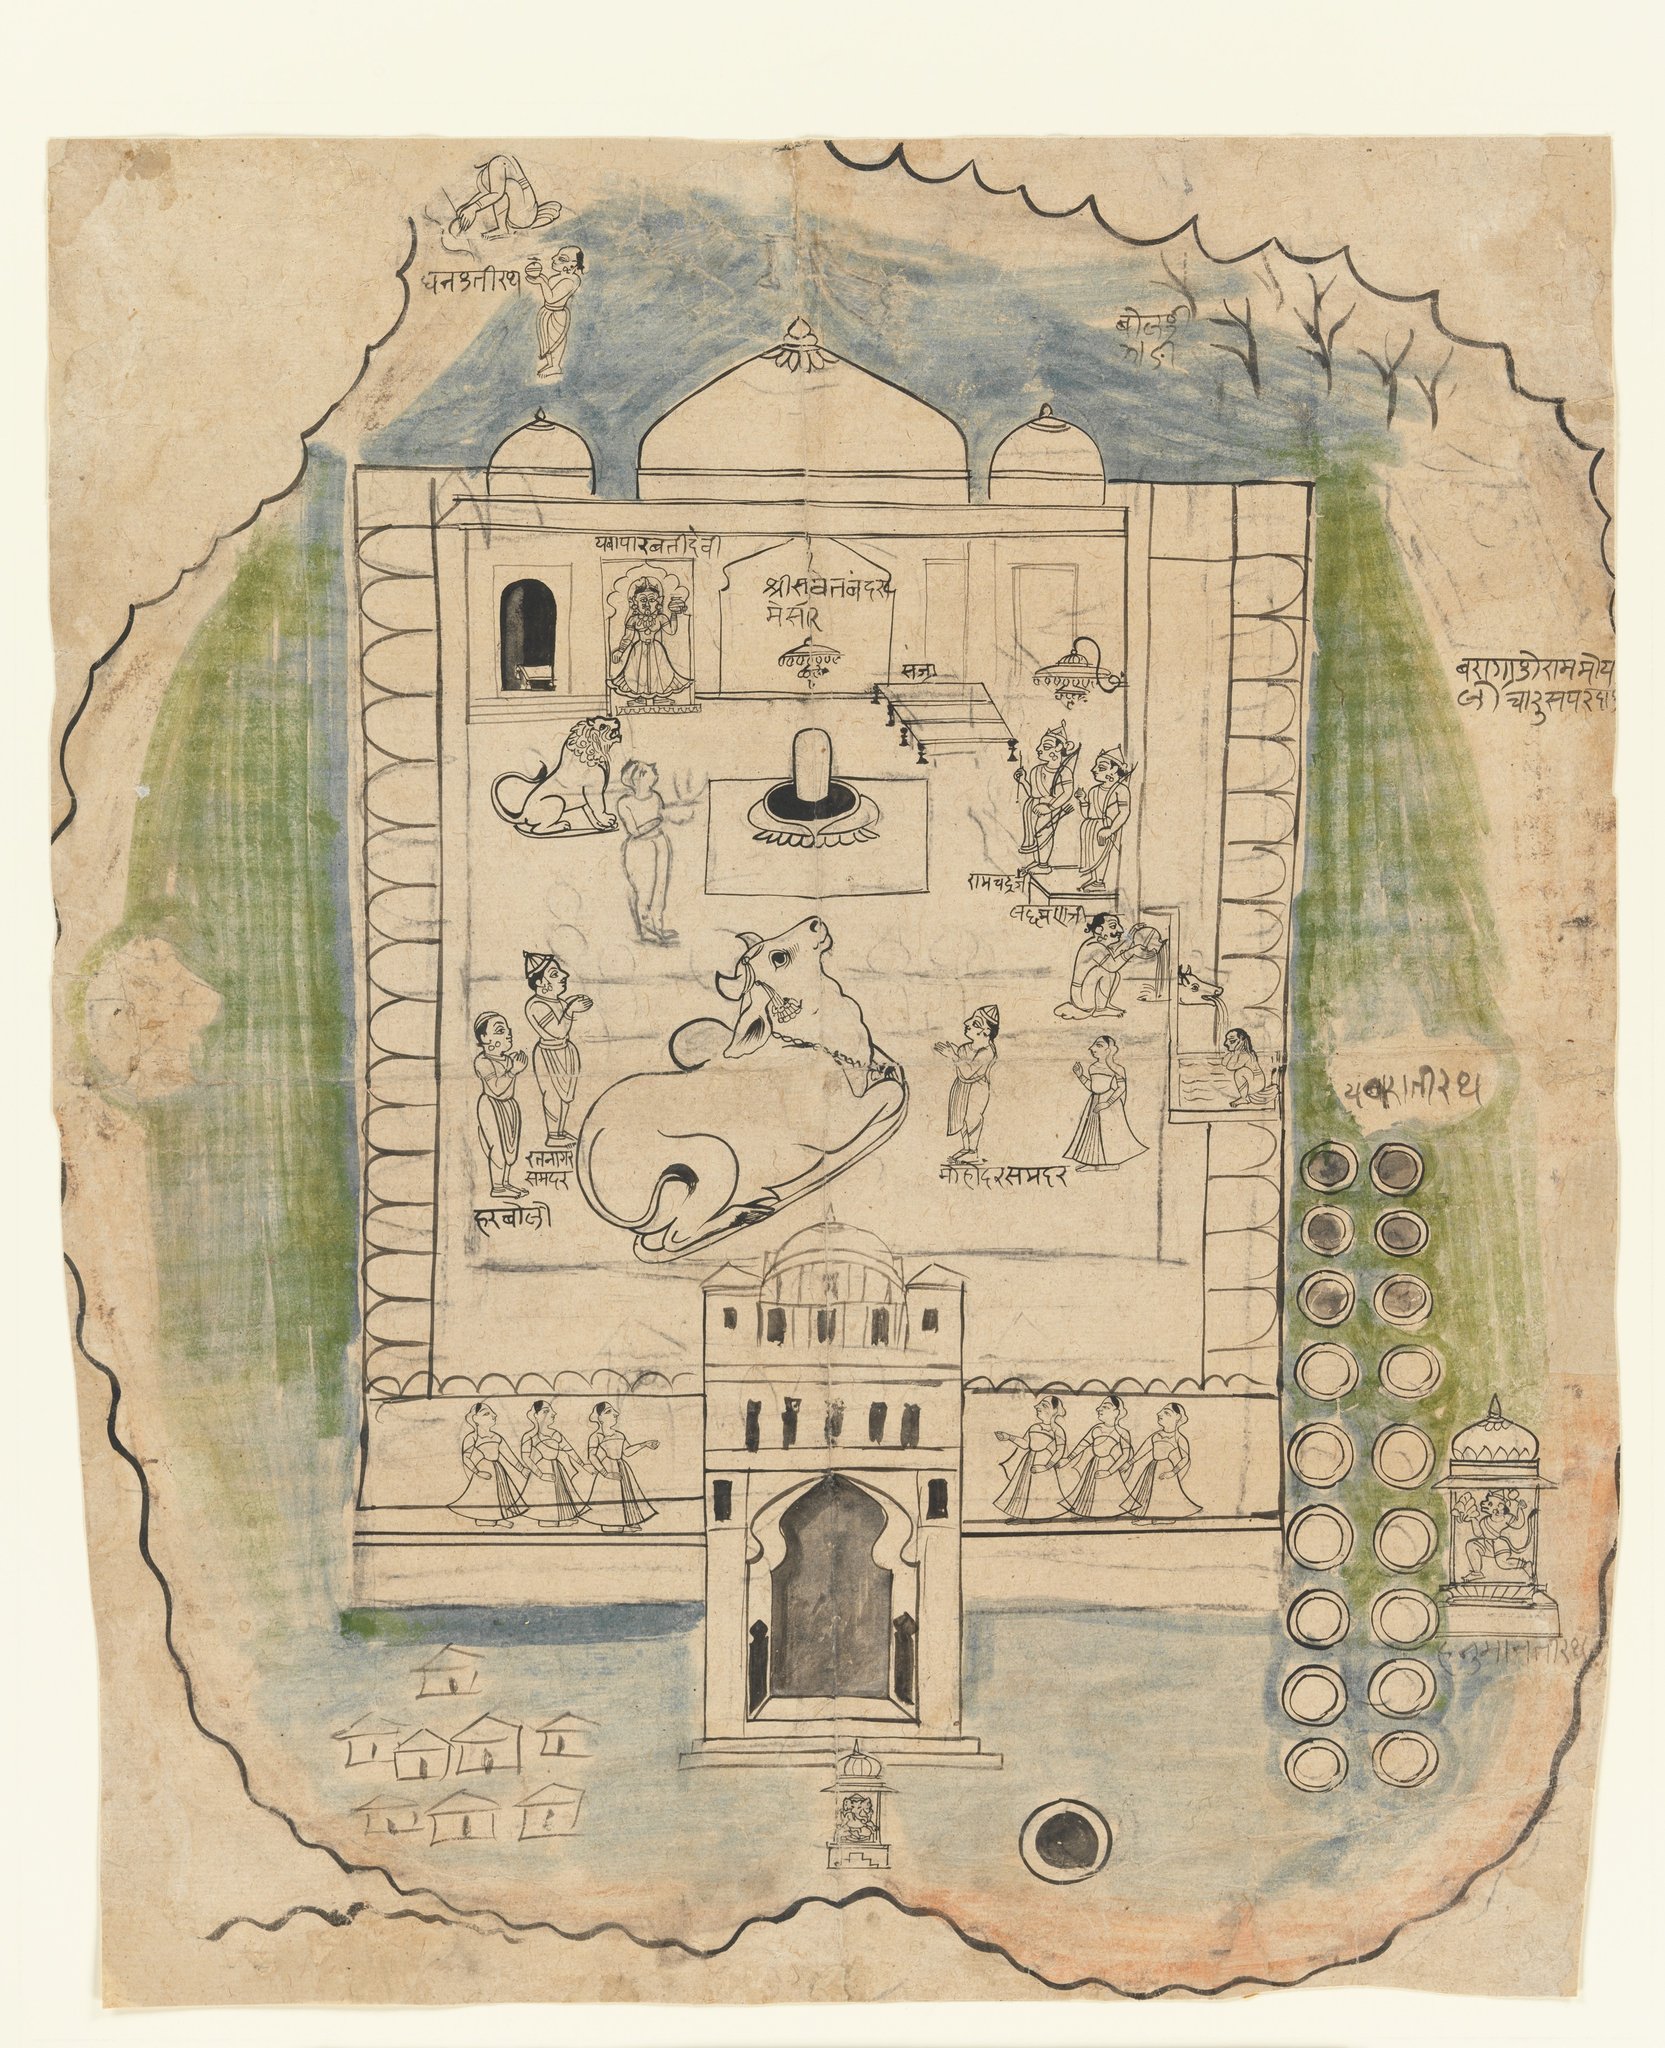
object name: painting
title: Linga Temple Compound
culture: indian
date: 1867-1900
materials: ink, paper, watercolor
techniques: wash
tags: temples,men,women,cows,lions,shiva